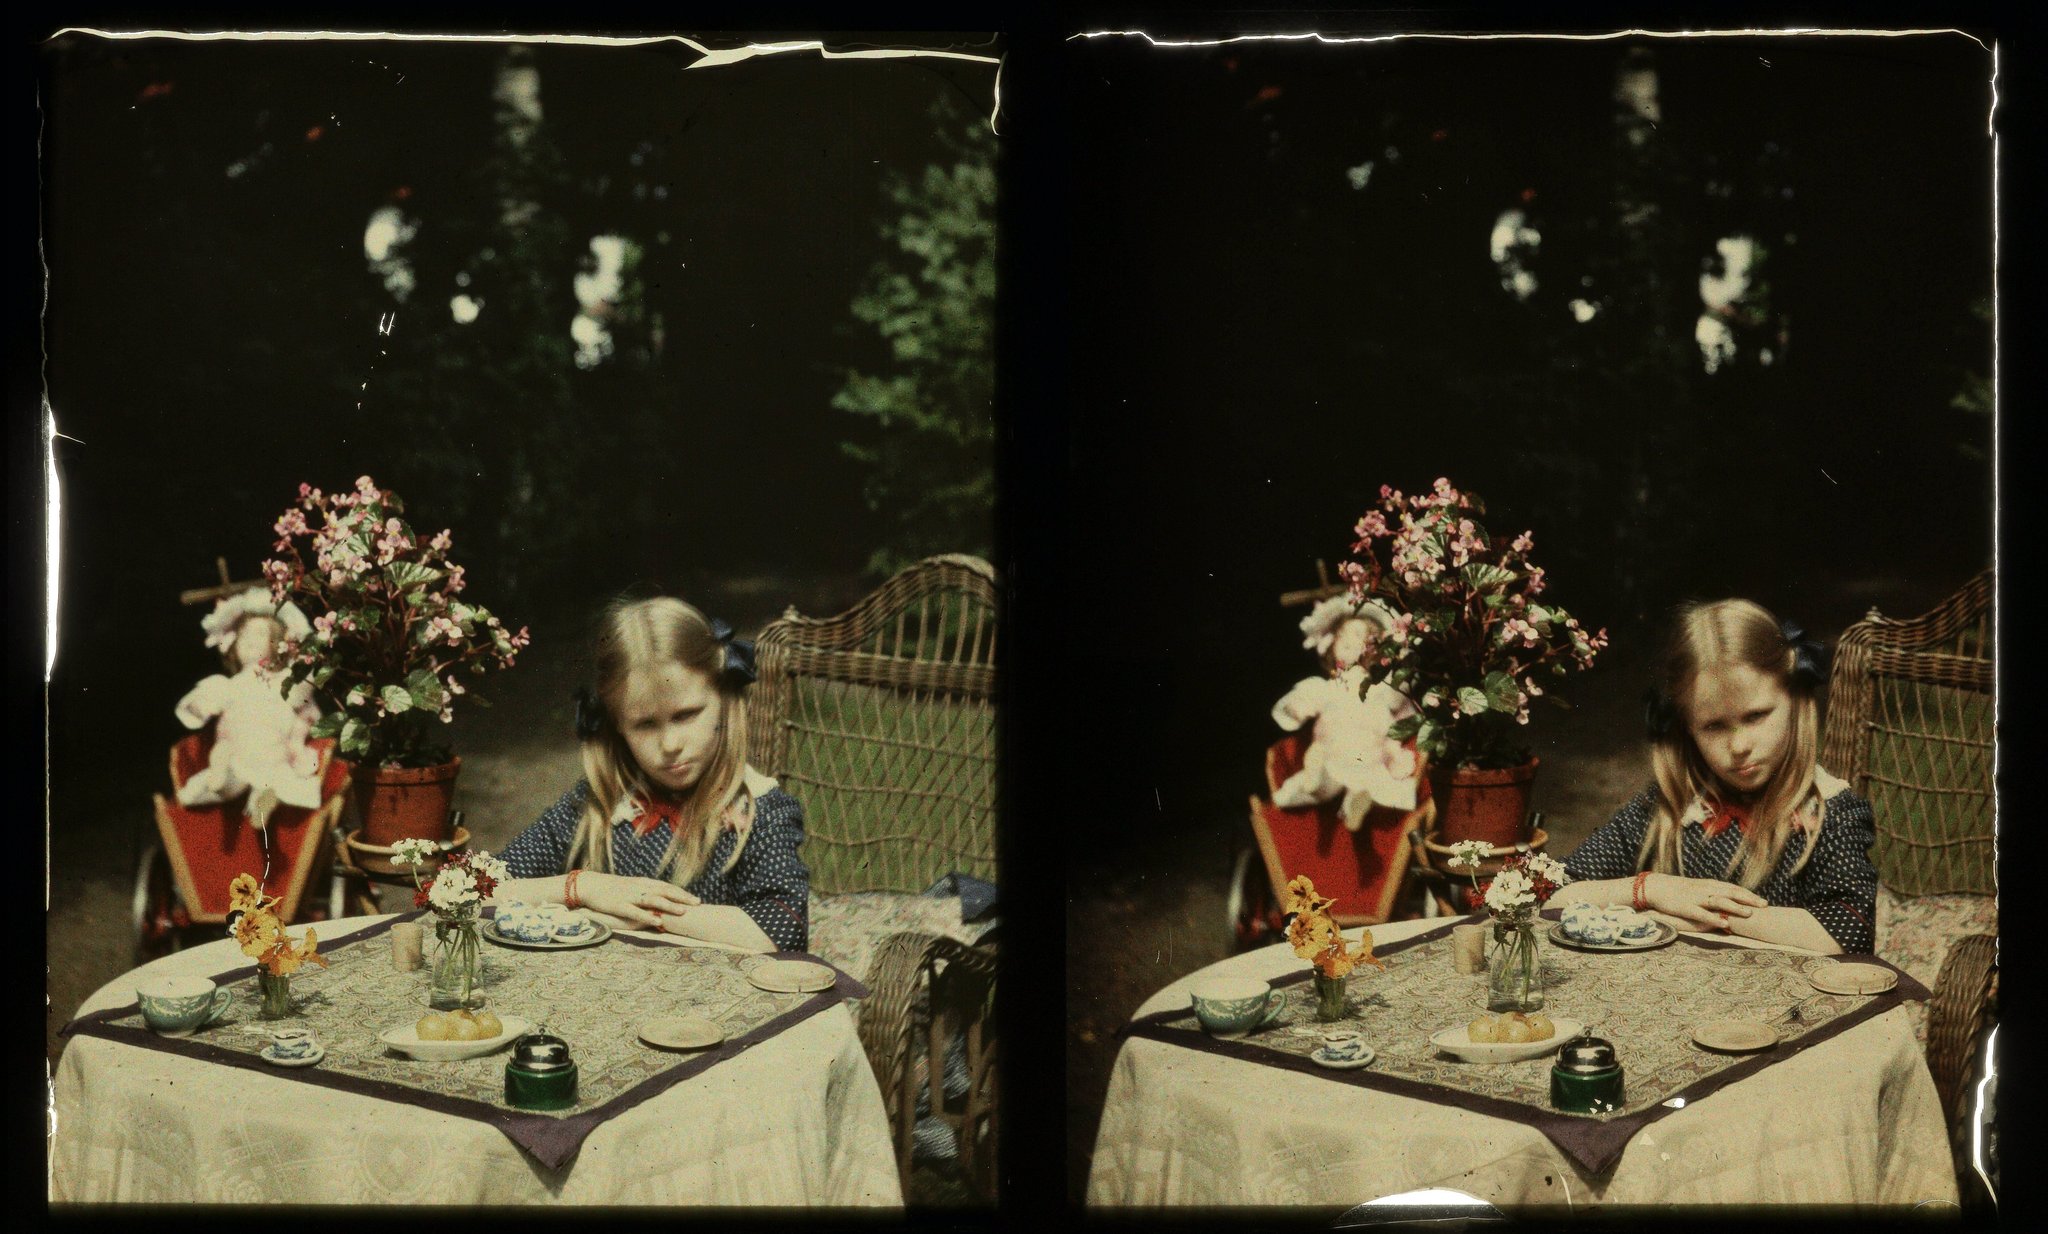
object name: color slide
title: Portret van een meisje zittend aan een gedekte tafel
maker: Anonymous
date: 1907-1930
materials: glass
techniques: autochrome process, slide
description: Portret van een meisje, gekleed in een donkerblauwe jurk, zittend aan een gedekte tafel, met links van haar een pot met bloemen en een pop op een kinderwagen (?).